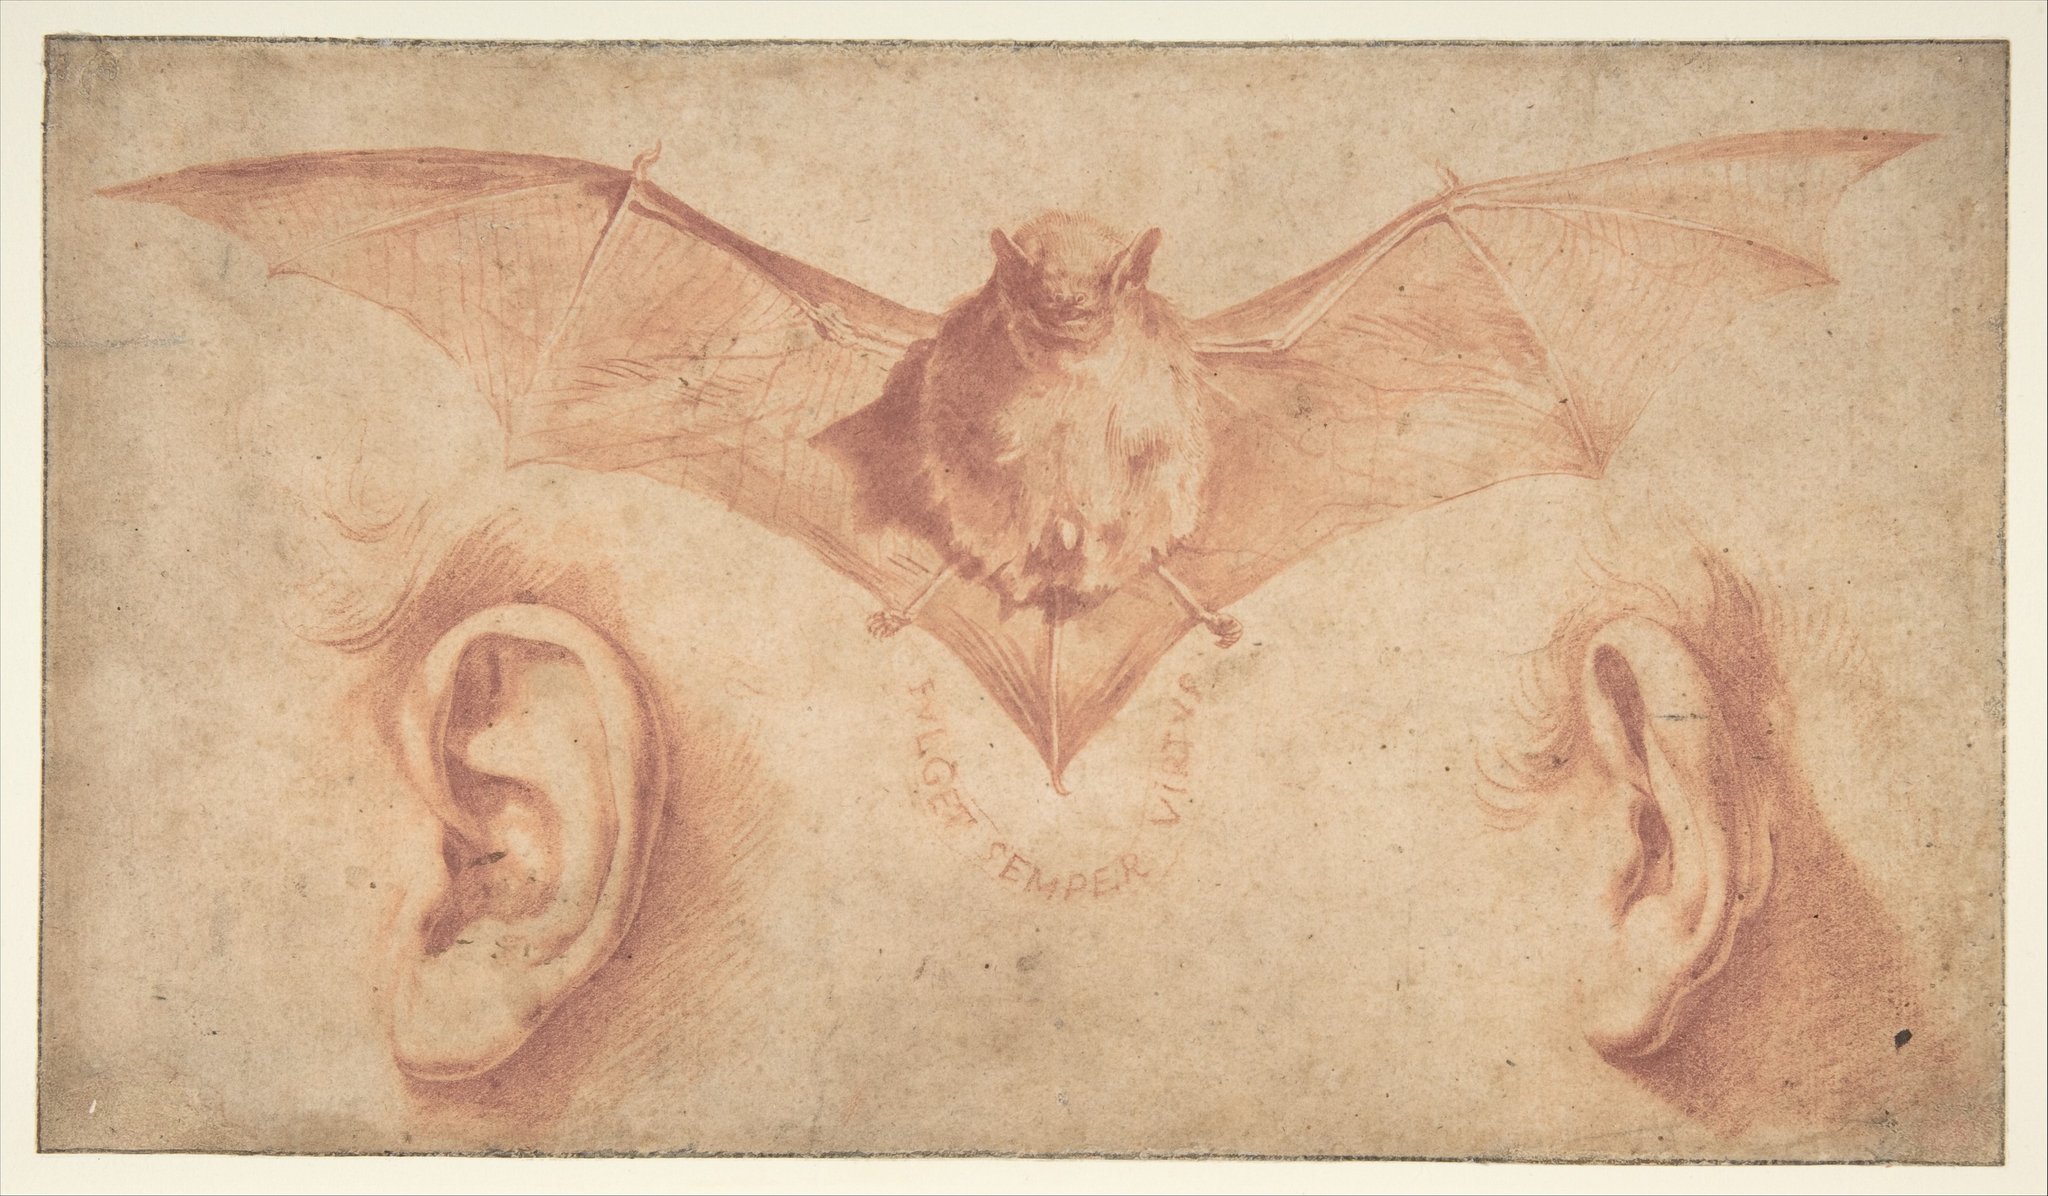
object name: drawing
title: Studies of Two Ears and of a Bat. Below, the motto: FULGET SEMPER VIRTUS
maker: jusepe de ribera (called lo spagnoletto)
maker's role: artist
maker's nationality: spanish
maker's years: 1591-1652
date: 1591-1652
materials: chalk, paper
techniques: brush, wash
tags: bats